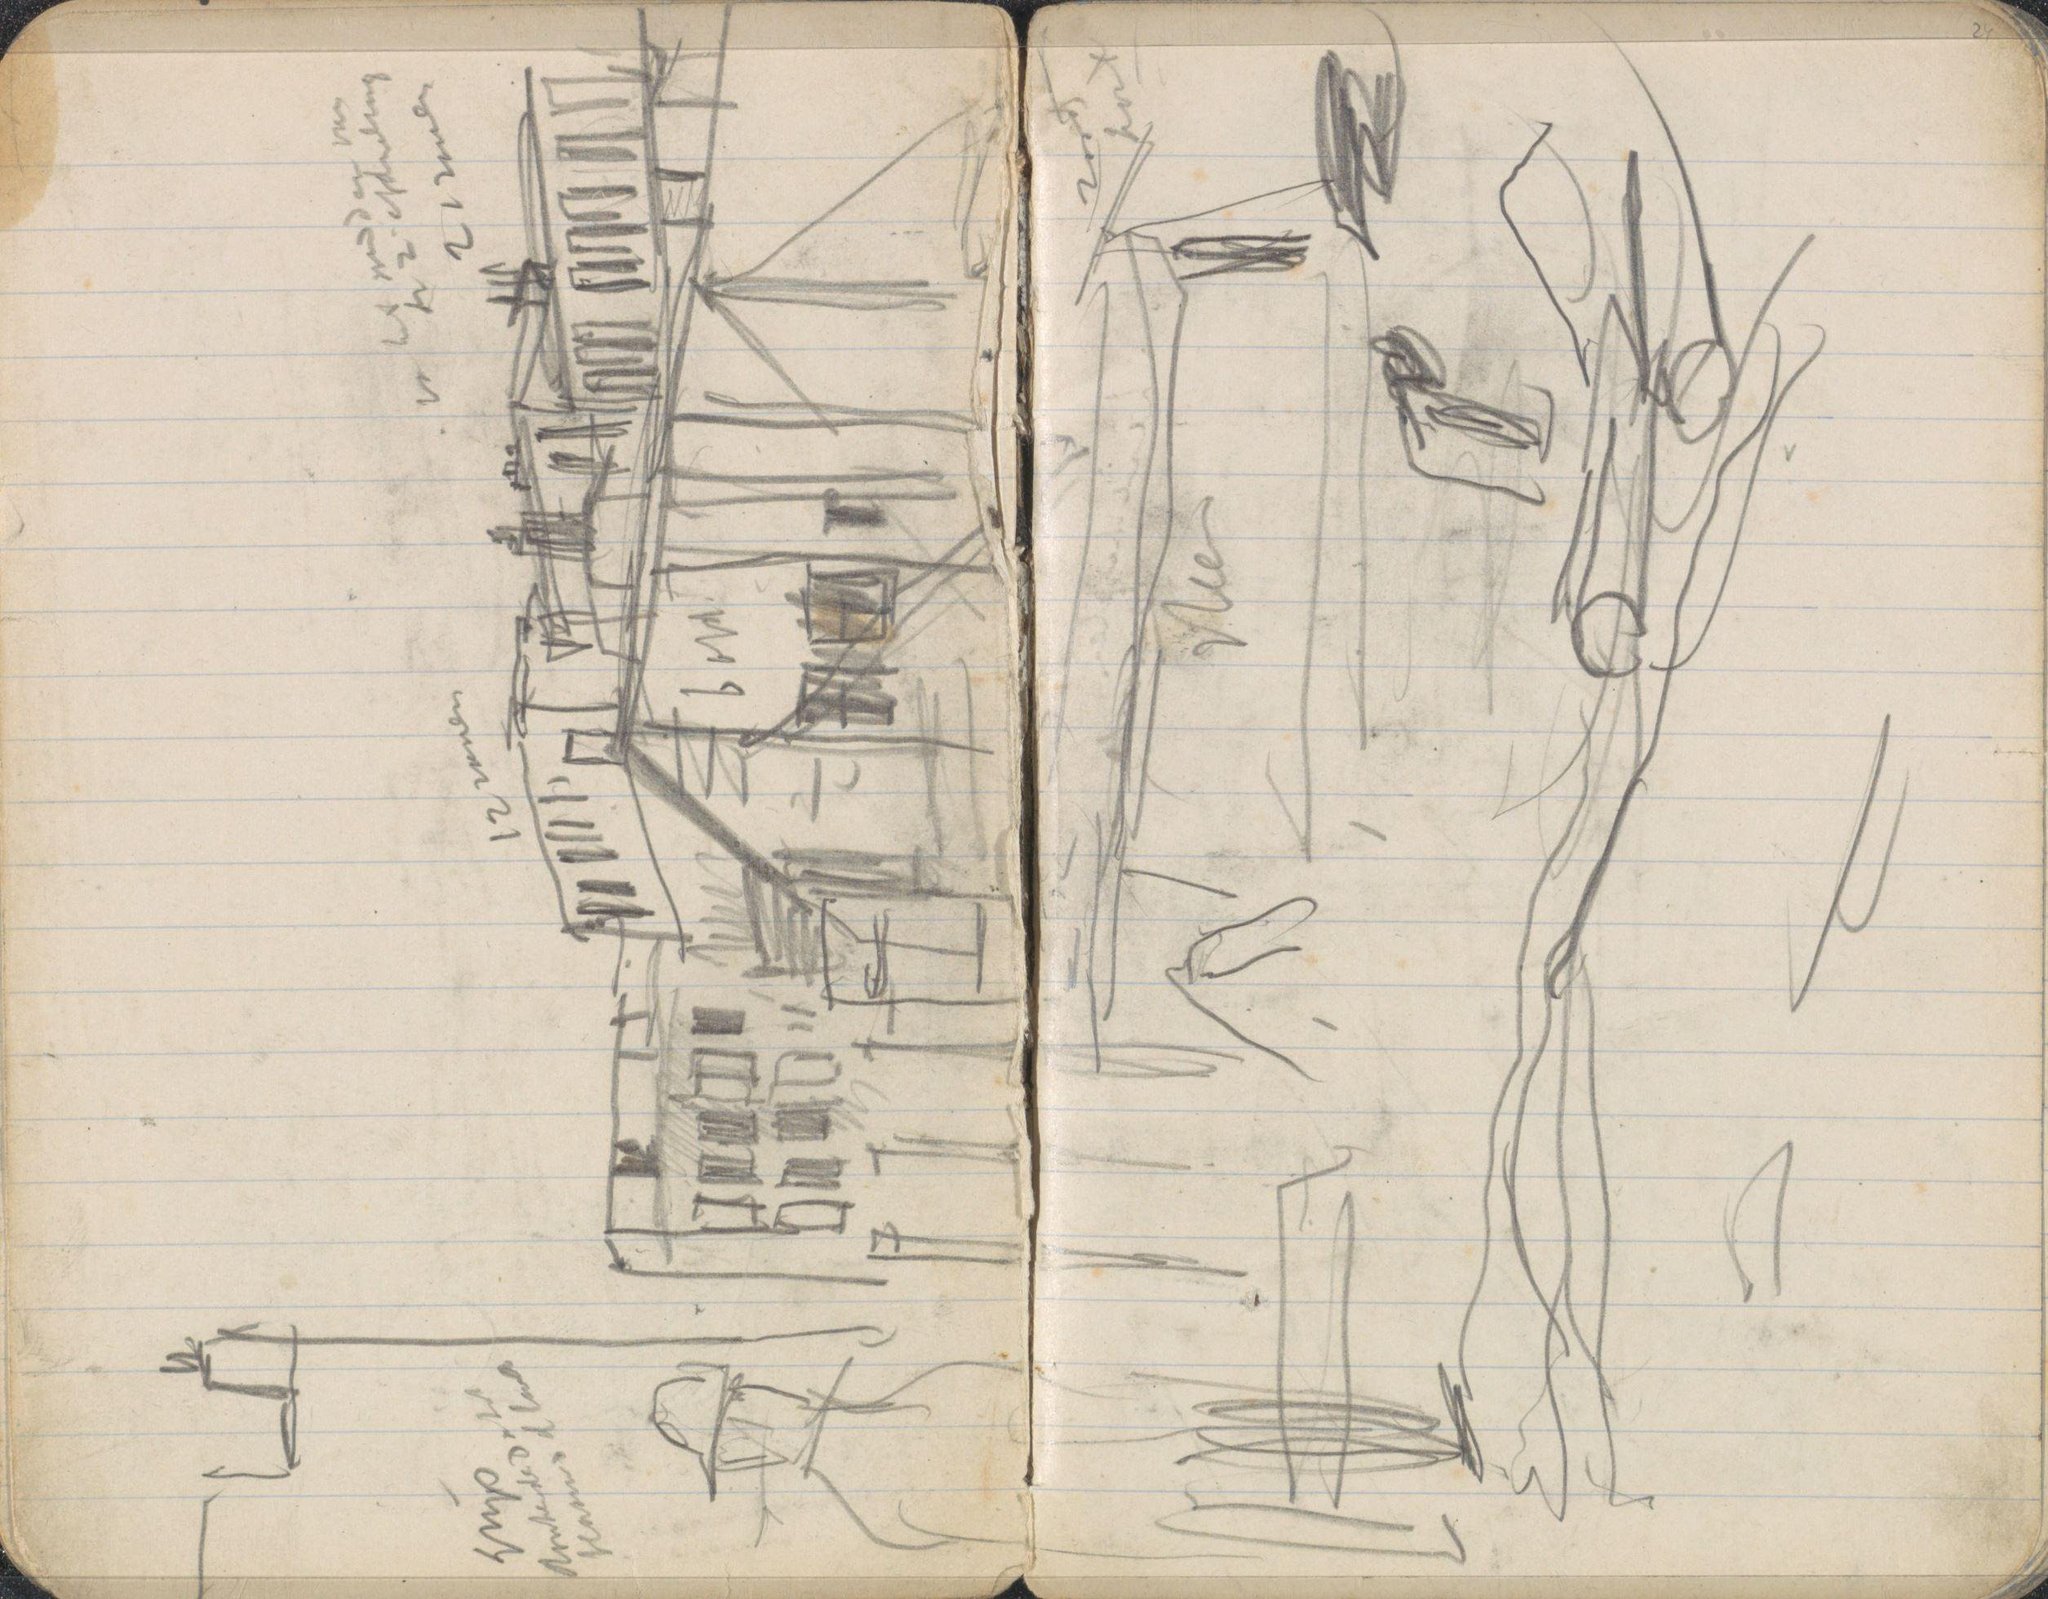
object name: sketchbook leaf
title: Gezicht in Amsterdam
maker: george hendrik breitner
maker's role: draughtsman, painter, print maker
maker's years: 1857-1923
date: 1896-1897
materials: pencil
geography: amsterdam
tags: urban housing, city-view, and landscape with man-made constructions (+ city(-scape) with figures, staffage), amsterdam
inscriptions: annotation: ‘12 ramen/ in het midden van/ de z-afdwaling[?]/ 2 ramen/ bord/ steen’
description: Vooraan een figuur. Pagina 23 en pagina 24 uit een schetsboek met 39 bladen.